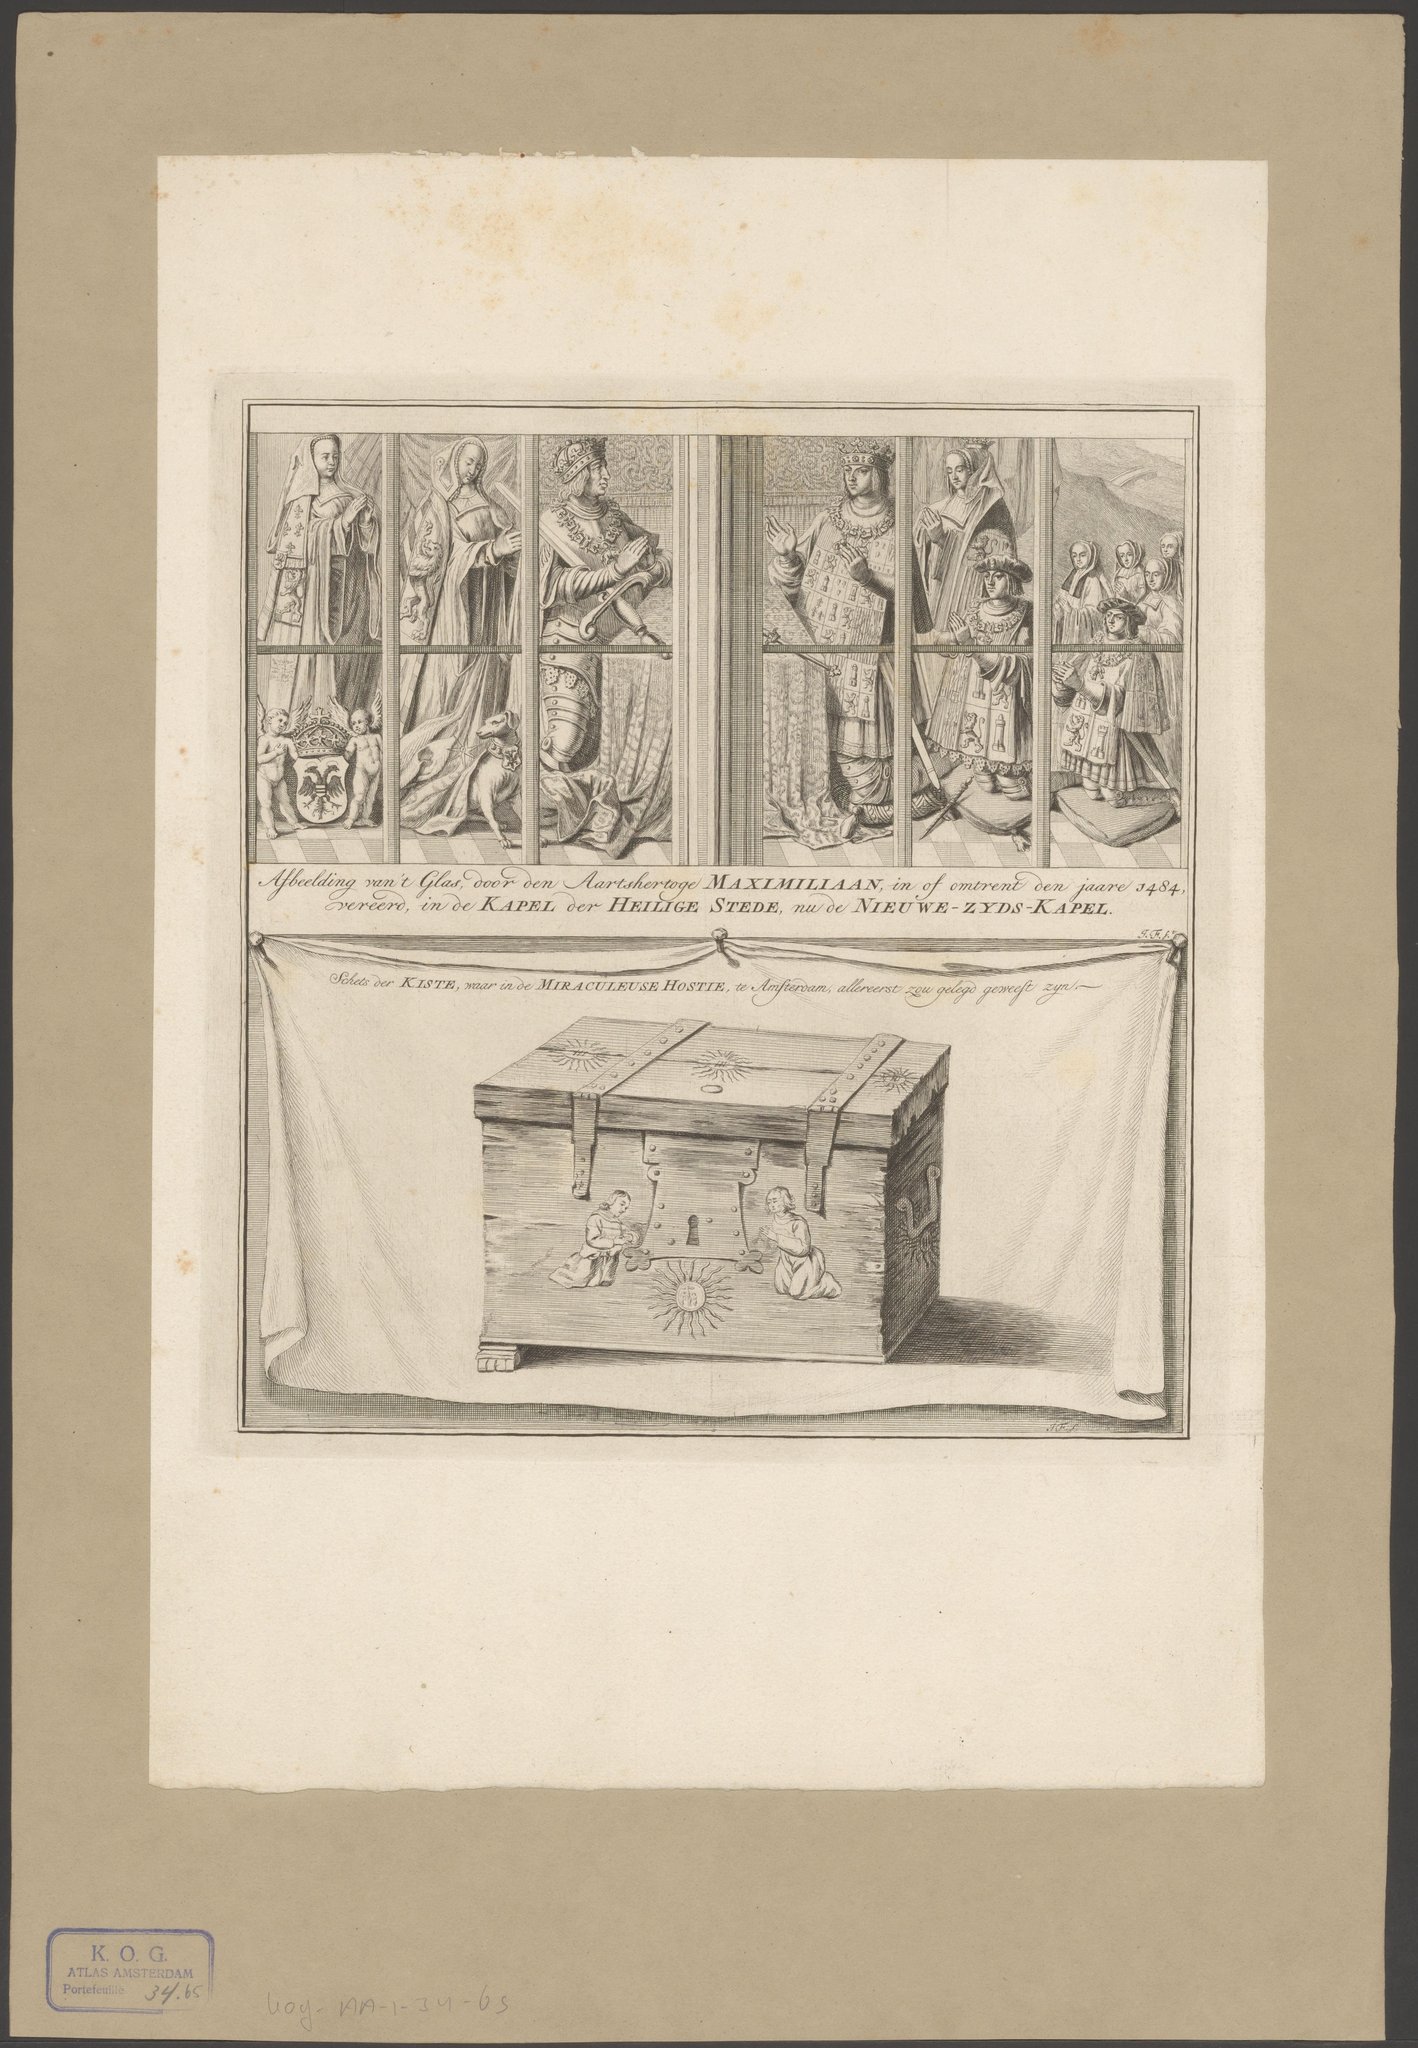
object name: print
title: Afbeelding van't Glas, door den Aartshertoge Maximiliaan, in of omtrent den jaar 1484, vereerd, in de Kapel der Heilige Stede, nu de Nieuwe-Zyds-Kapel / Schets der Kiste, waar in de Miraculeuse Hostie, te Amsterdam, allereerst zou gelegd geweest zyn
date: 1765-1782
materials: paper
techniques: engraving, etching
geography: harlingen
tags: maria (hertogin van bourgondië), brussels, eleonora van oostenrijk (koningin van portugal en frankrijk), maximilian i (holy roman emperor), bruges, filips de schone (hertog van bourgondië), ghent, charles v (holy roman emperor and king of spain), ferdinand i van habsburg (duits keizer), maria van hongarije (landvoogdes der nederlanden), church-window, e.g. rose-window, chest, coffer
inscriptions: collector's mark: Lugt 1641b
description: Prent mogelijk uit: Wagenaar, Jan. Amsterdam, in zyne opkomst, aanwas, geschiedenissen (…). Amsterdam: Isaak Tirion, 1765, dl. 2. Of uit: Verzameling der fraaiste gezigten van Amsterdam in negen en zeventig afbeeldingen. Amsterdam en Harlingen: Petrus Conradi en Volkert van der Plaats, 1782.